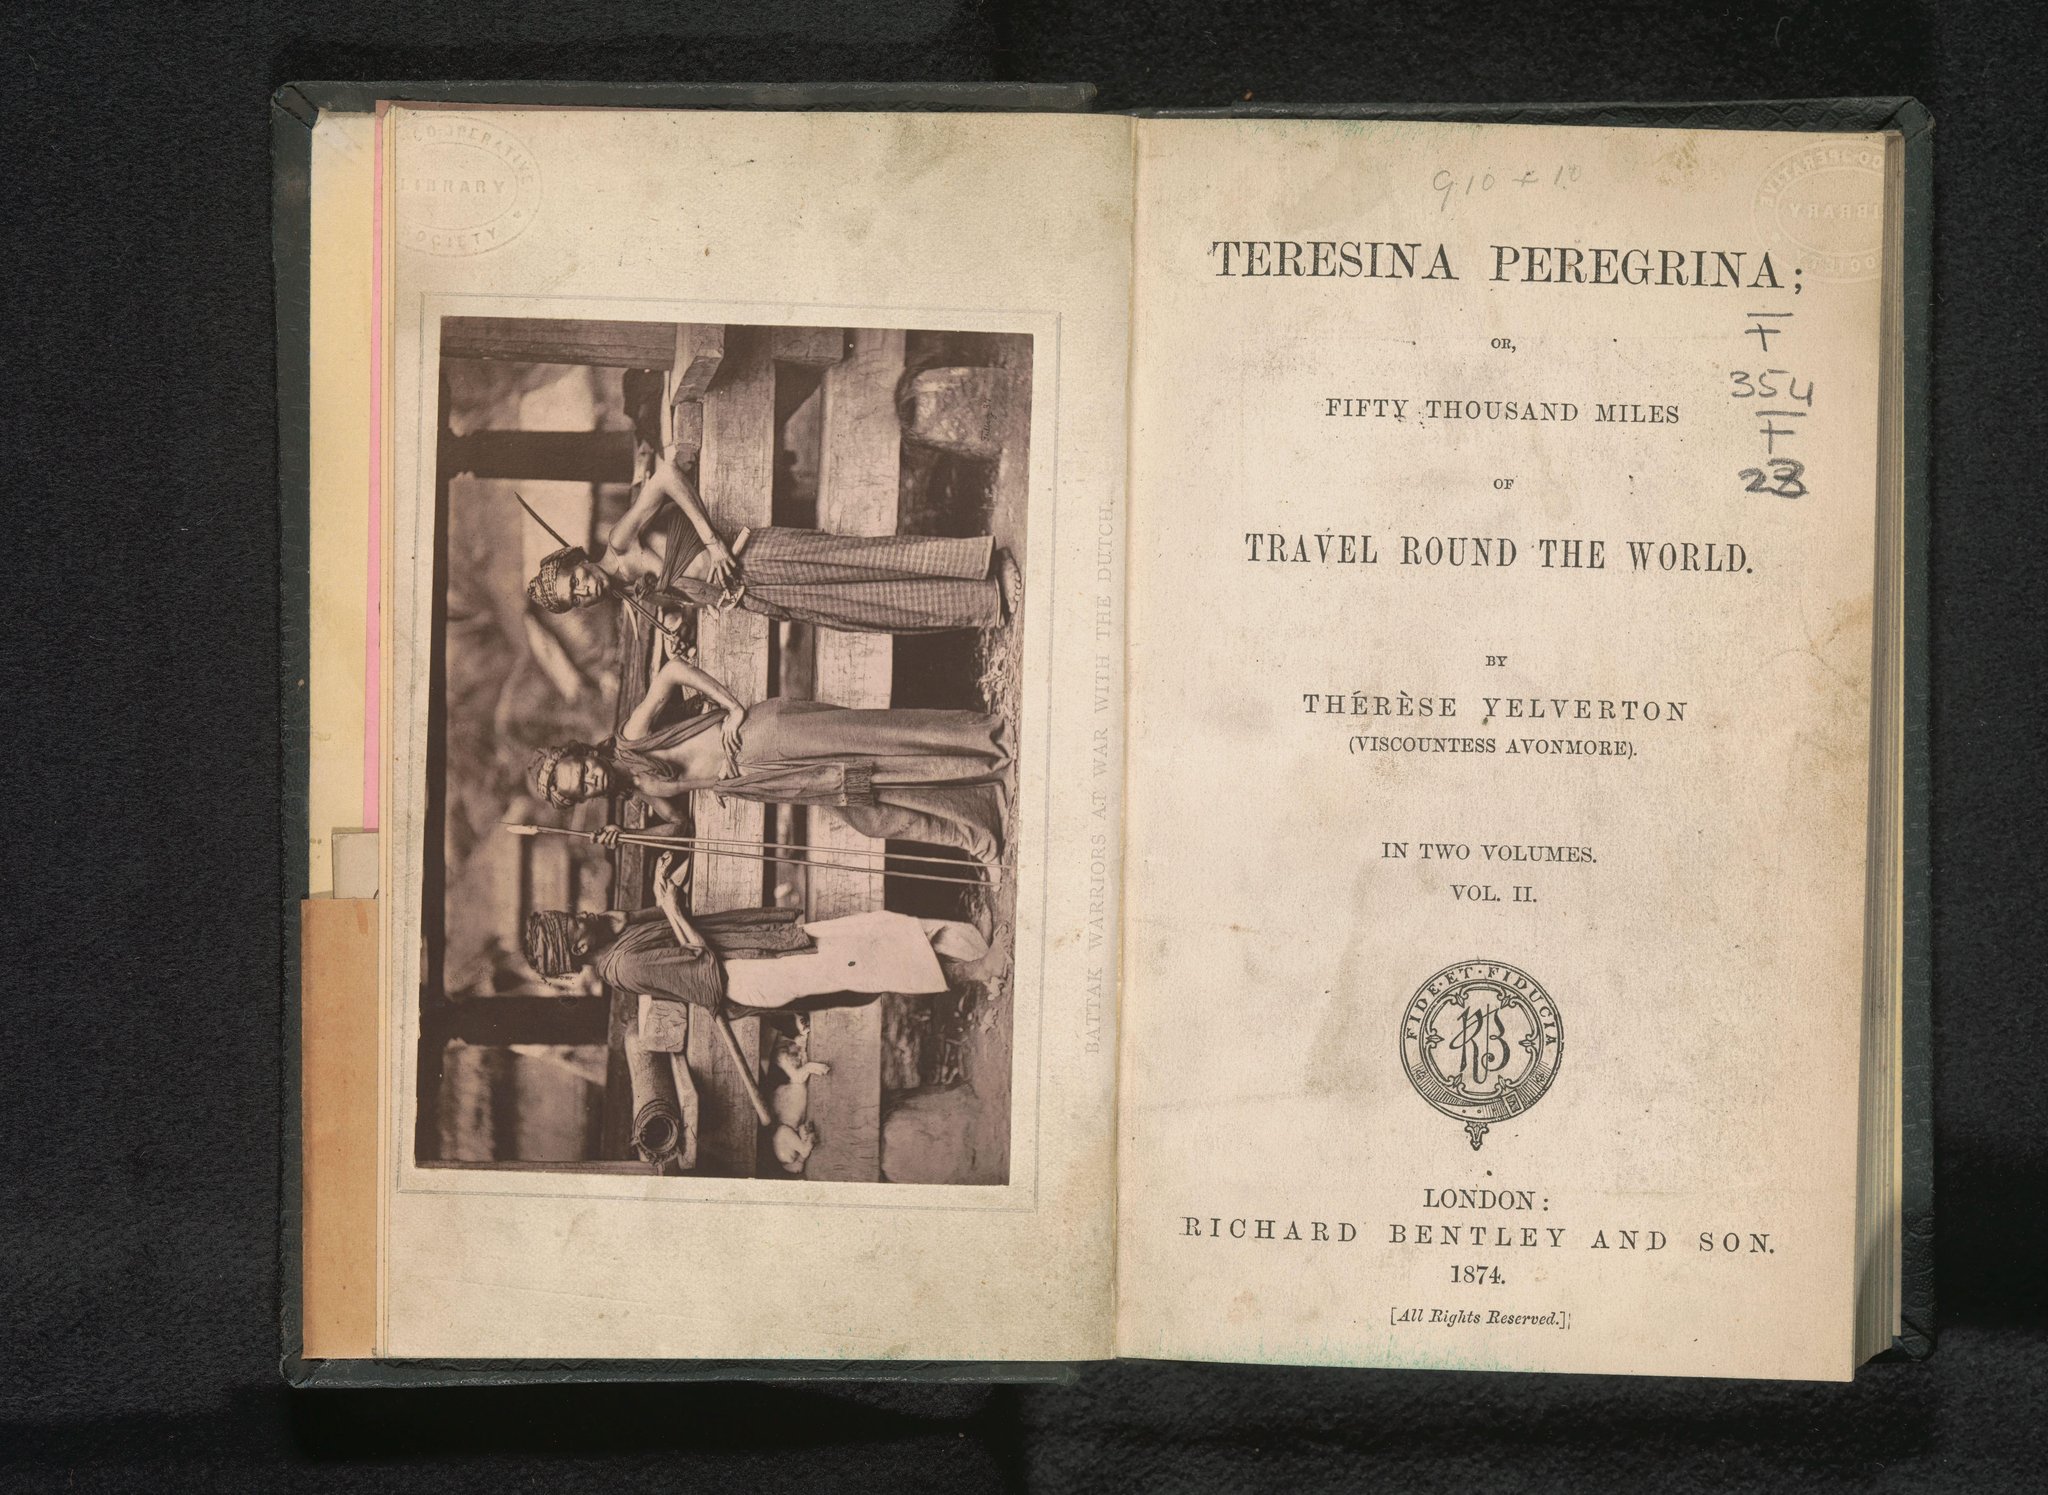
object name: book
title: Teresina peregrina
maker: theresa yelverton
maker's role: schrijver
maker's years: 1827-1881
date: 1874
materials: cardboard, leather, paper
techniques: printing, woodburytype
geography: london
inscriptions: inscription: ‘Bury District (...) as expensive to replace.’